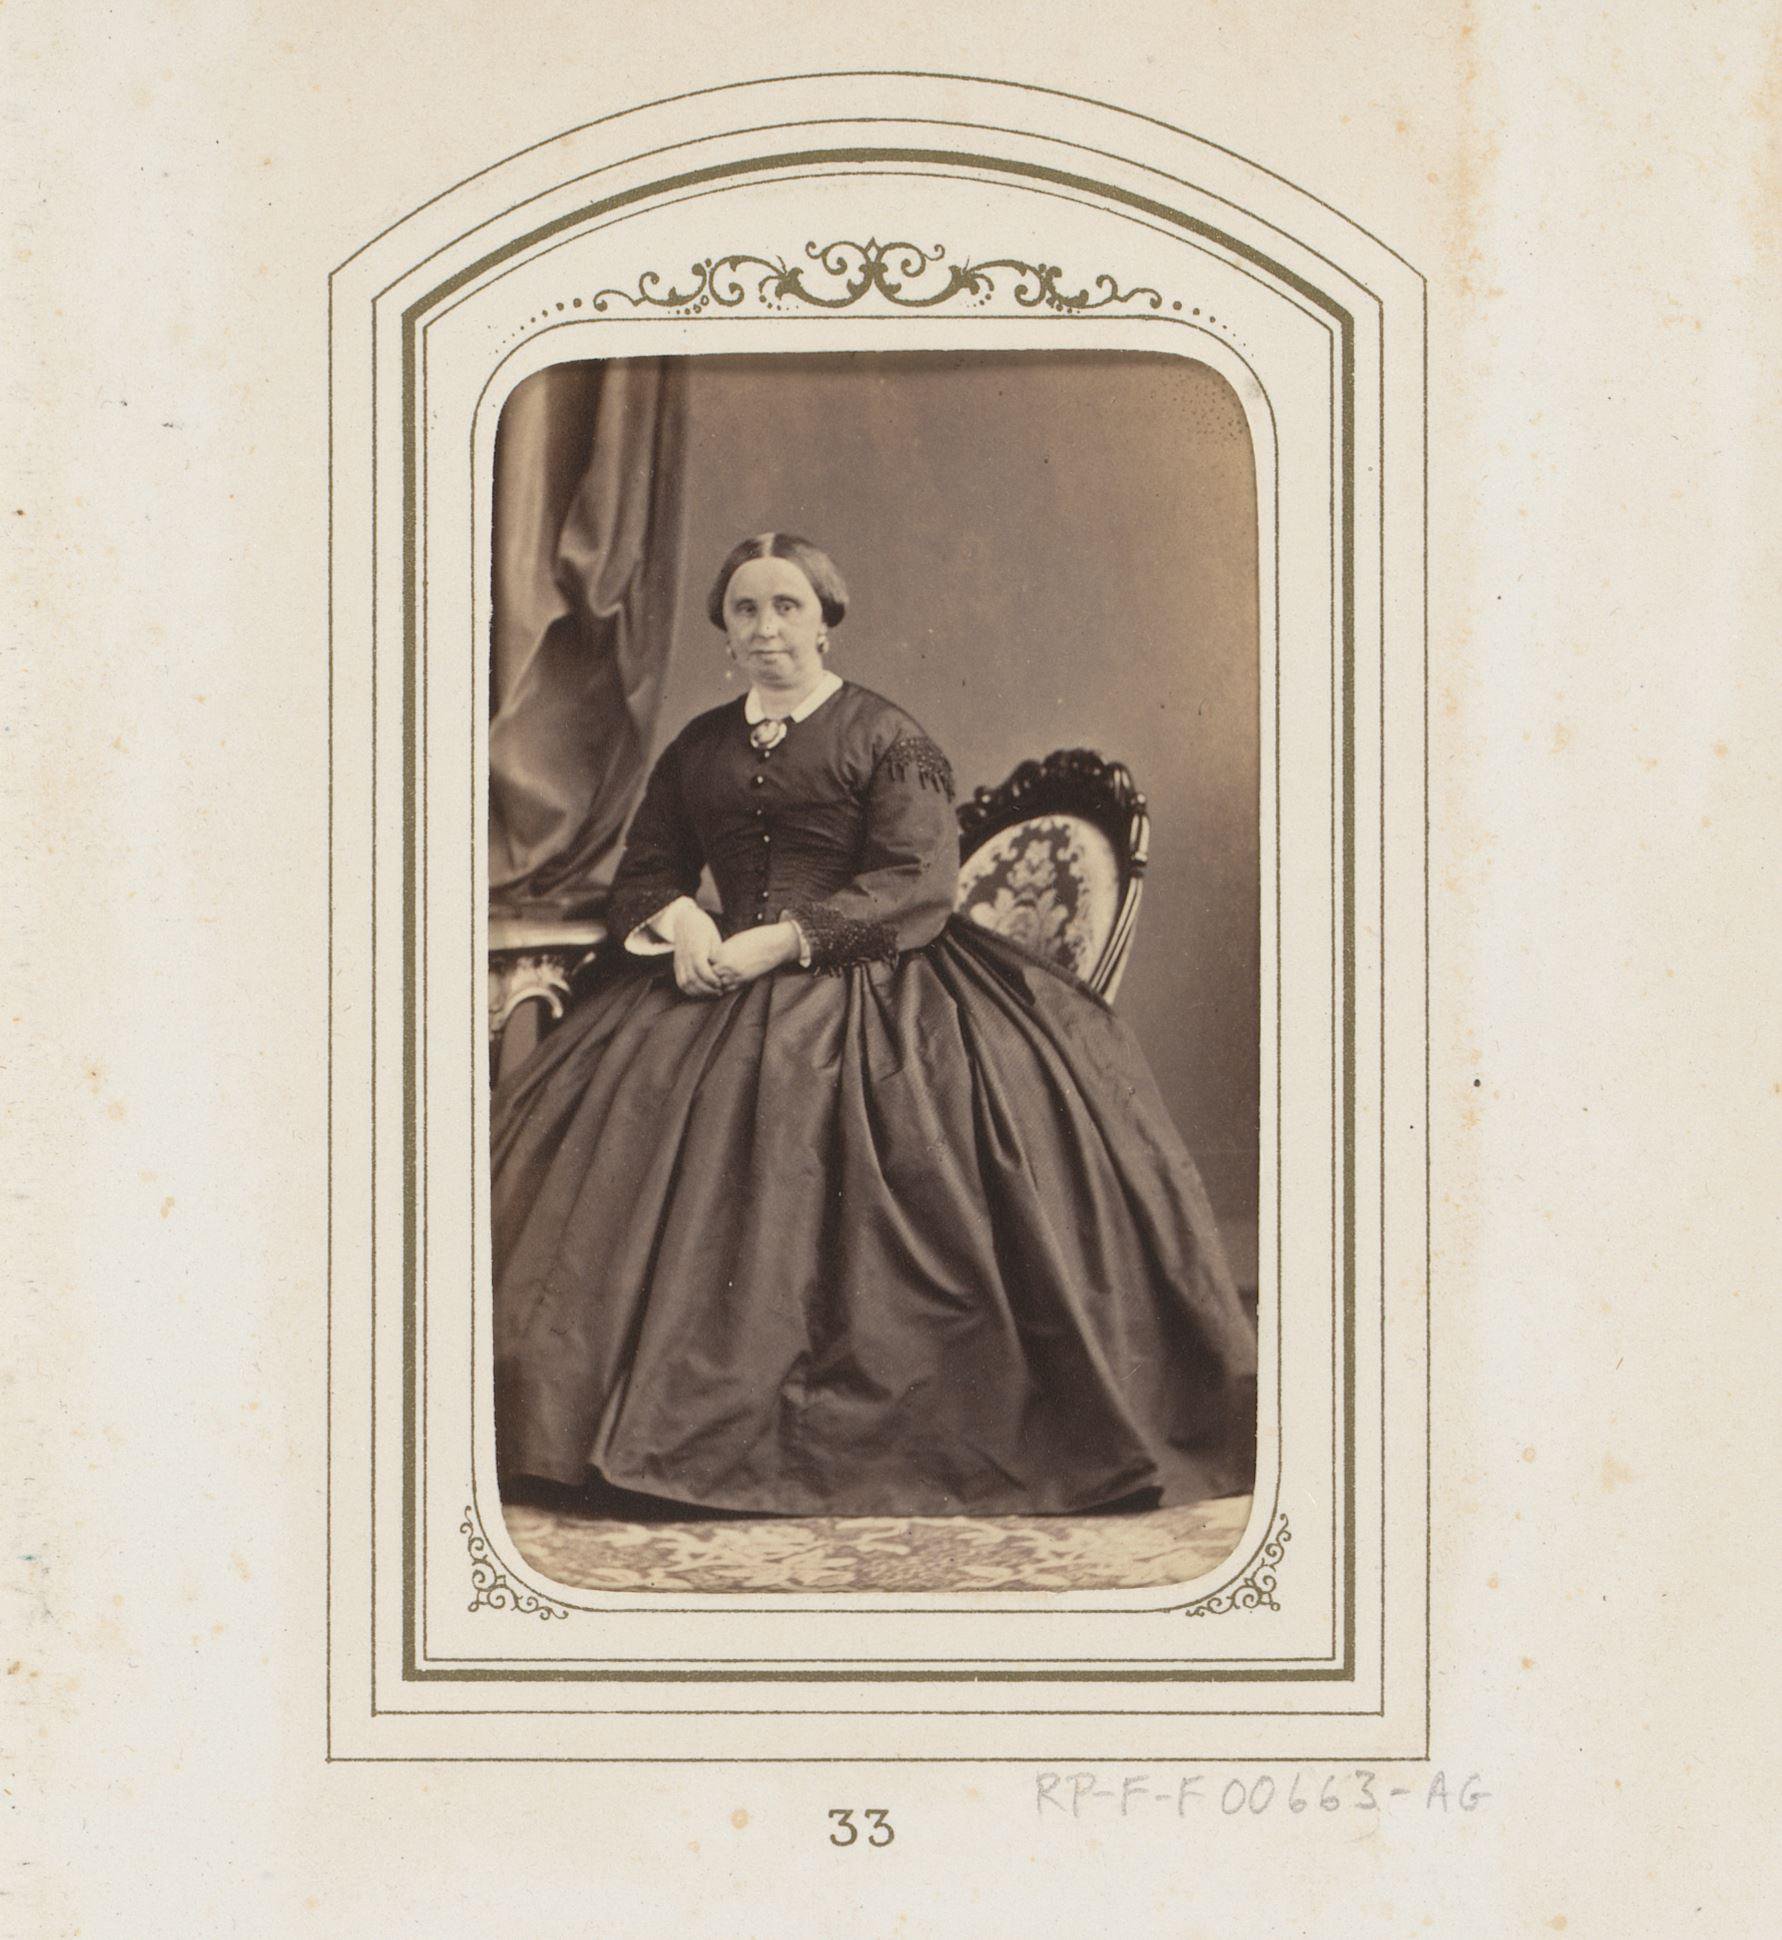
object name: photograph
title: Portret van een zittende vrouw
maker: maurits verveer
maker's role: painter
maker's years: 1817-1903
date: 1861-1883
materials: cardboard, photographic support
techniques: albumen print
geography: the hague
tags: historical persons - bb - woman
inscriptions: inscription: ‘M. Verveer/ Photographe (...)/ 52, Zeestraat, 52/ La Haye’, number: ‘33’